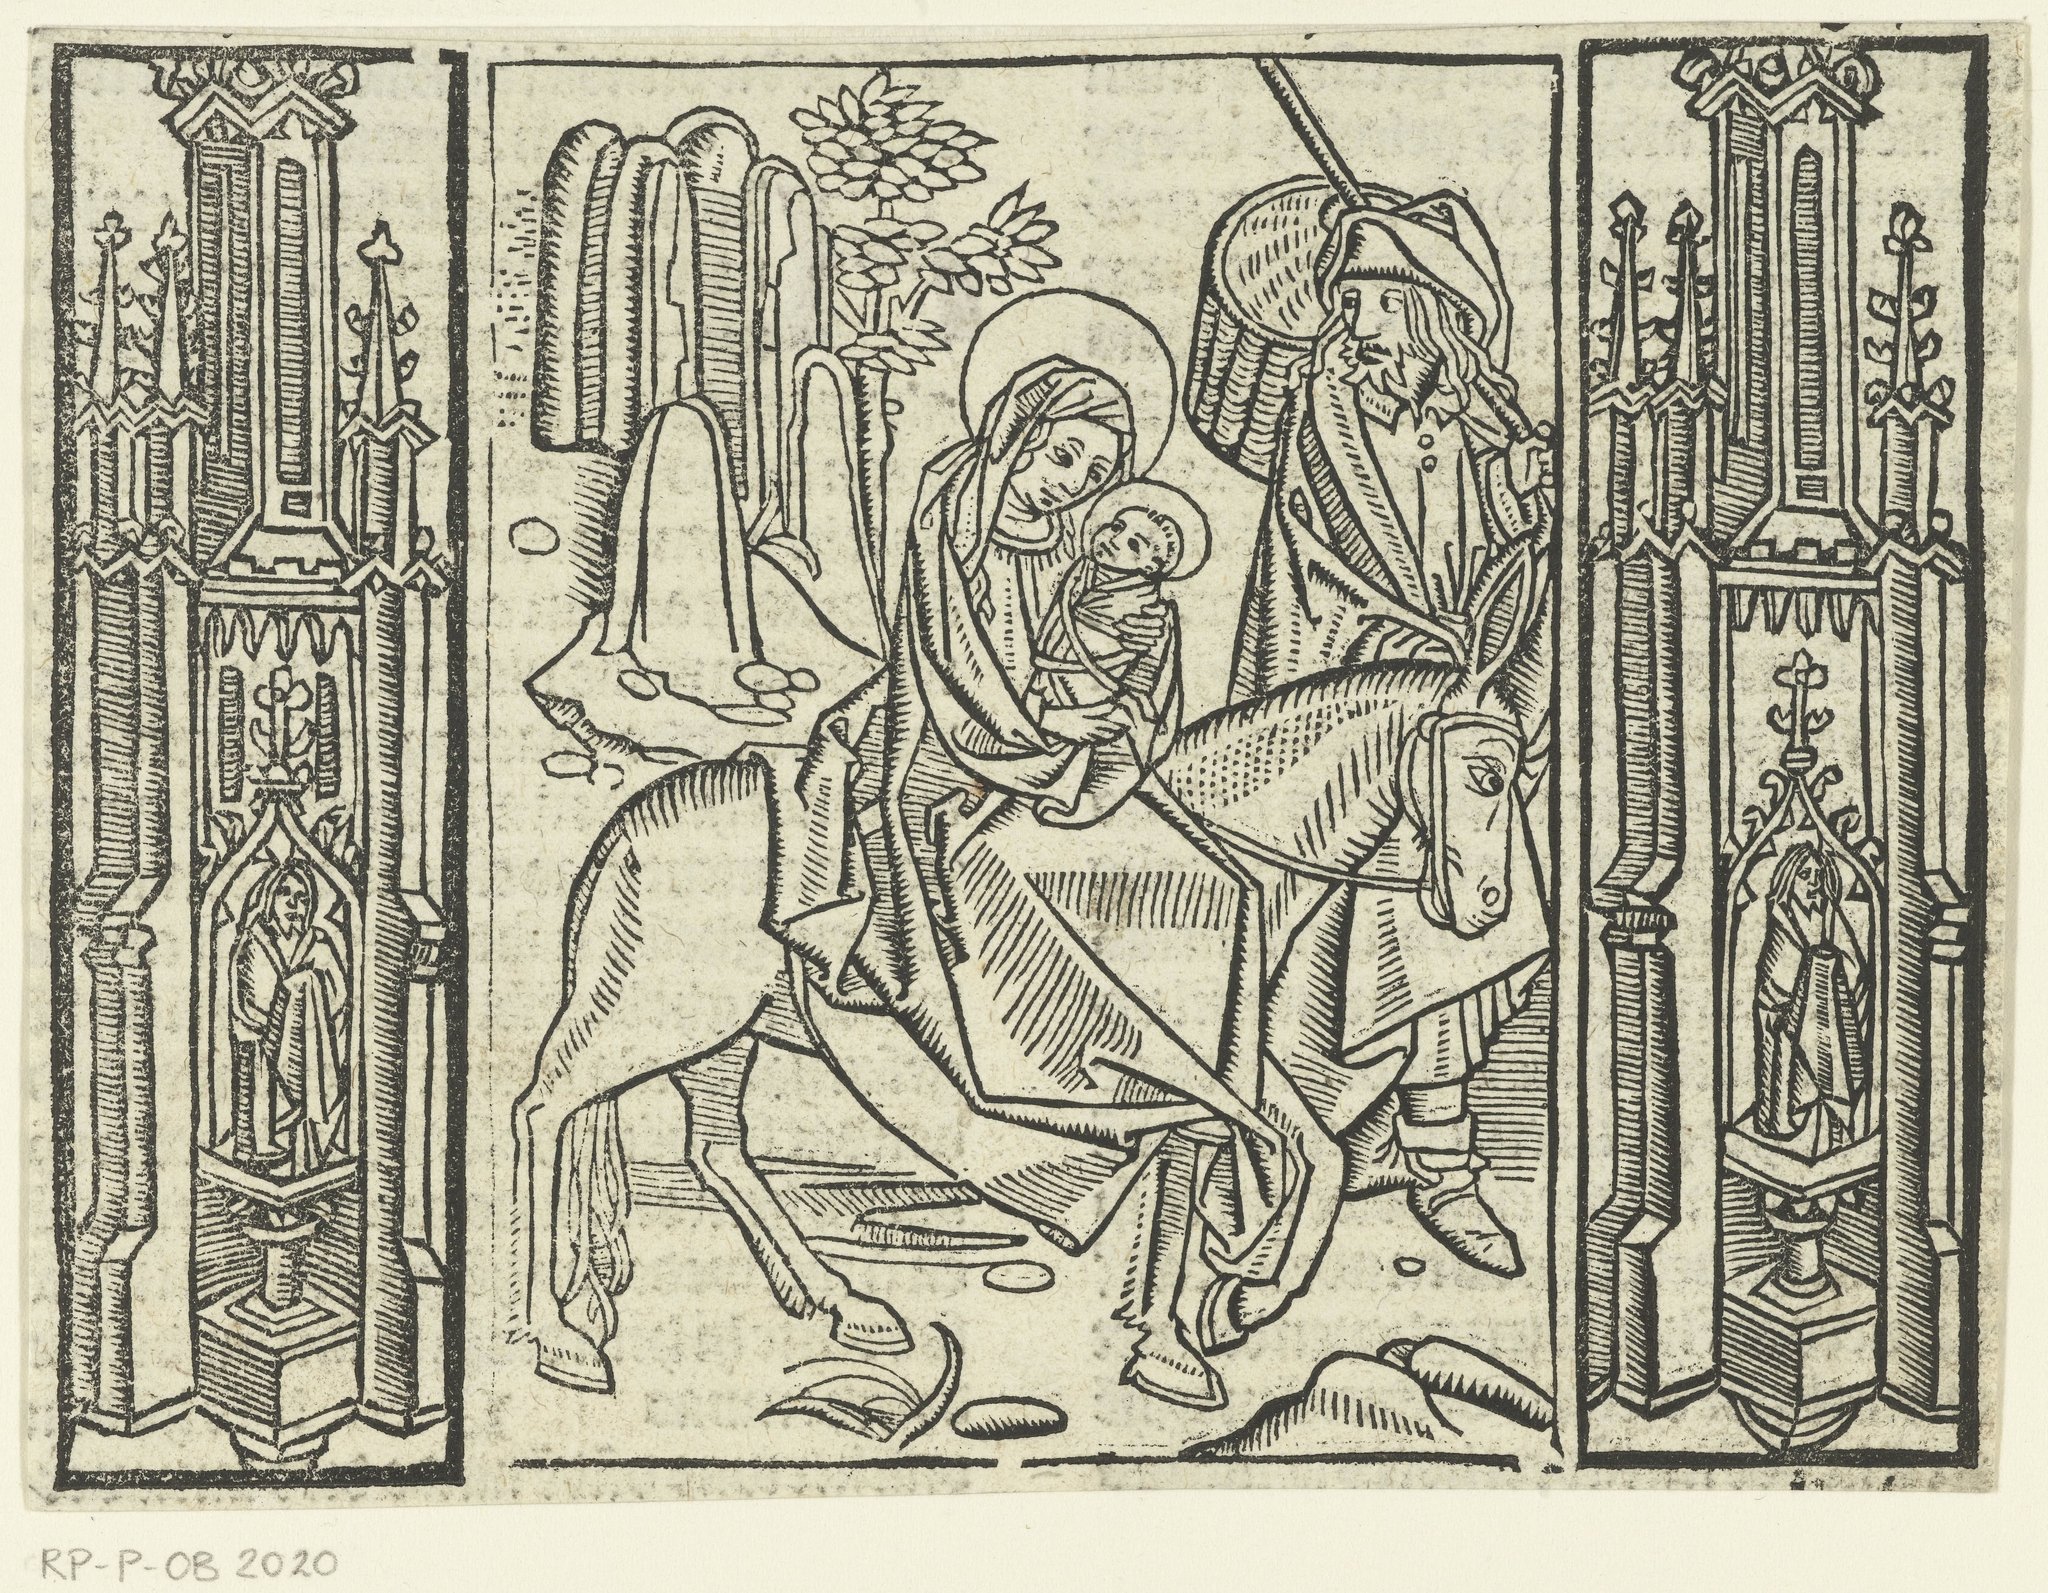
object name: print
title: De vlucht naar Egypte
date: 1480-1500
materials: paper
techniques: woodcut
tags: the flight into egypt: mary, joseph, the child (and sometimes others) on their way; mary usually riding on an ass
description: Eén blad van 113 uit Ludolphus de Saxonia, "Dit es dleué ons liefs heeren ihesu christi". Anonieme Nederlandse vertaling. Uitgegeven door Henrick Eckert van Homberch te Antwerpen in 1503. Botke, K. Deze 113 houtsneden, die meestal reeds in vroege Nederlandse boeken gebruikt zijn, worden toegeschreven aan de tweede Meester van Delft, de Meester van de Delbecq-Schreiber-passie en de Meester van de Virgo inter Virgines. In Conway (1884) en in "De gulden passer"(1951) zijn ook eerdere versies opgenomen. Botke, K.